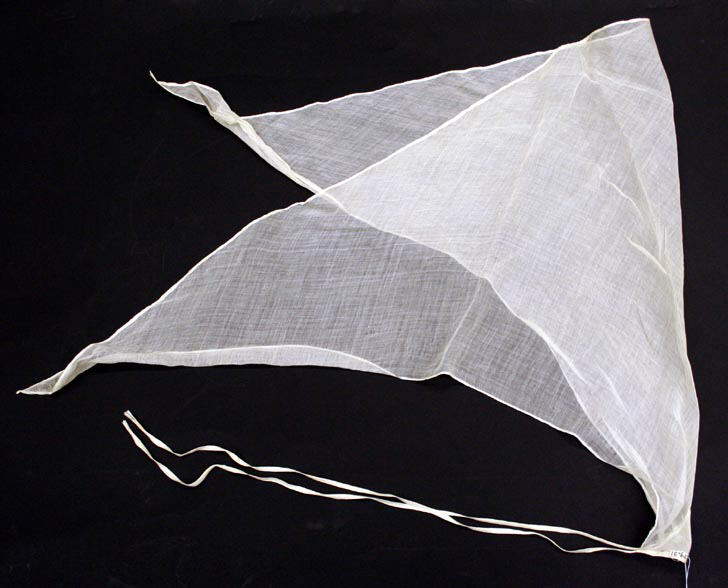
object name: kerchief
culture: american or european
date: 1700-1945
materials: cotton